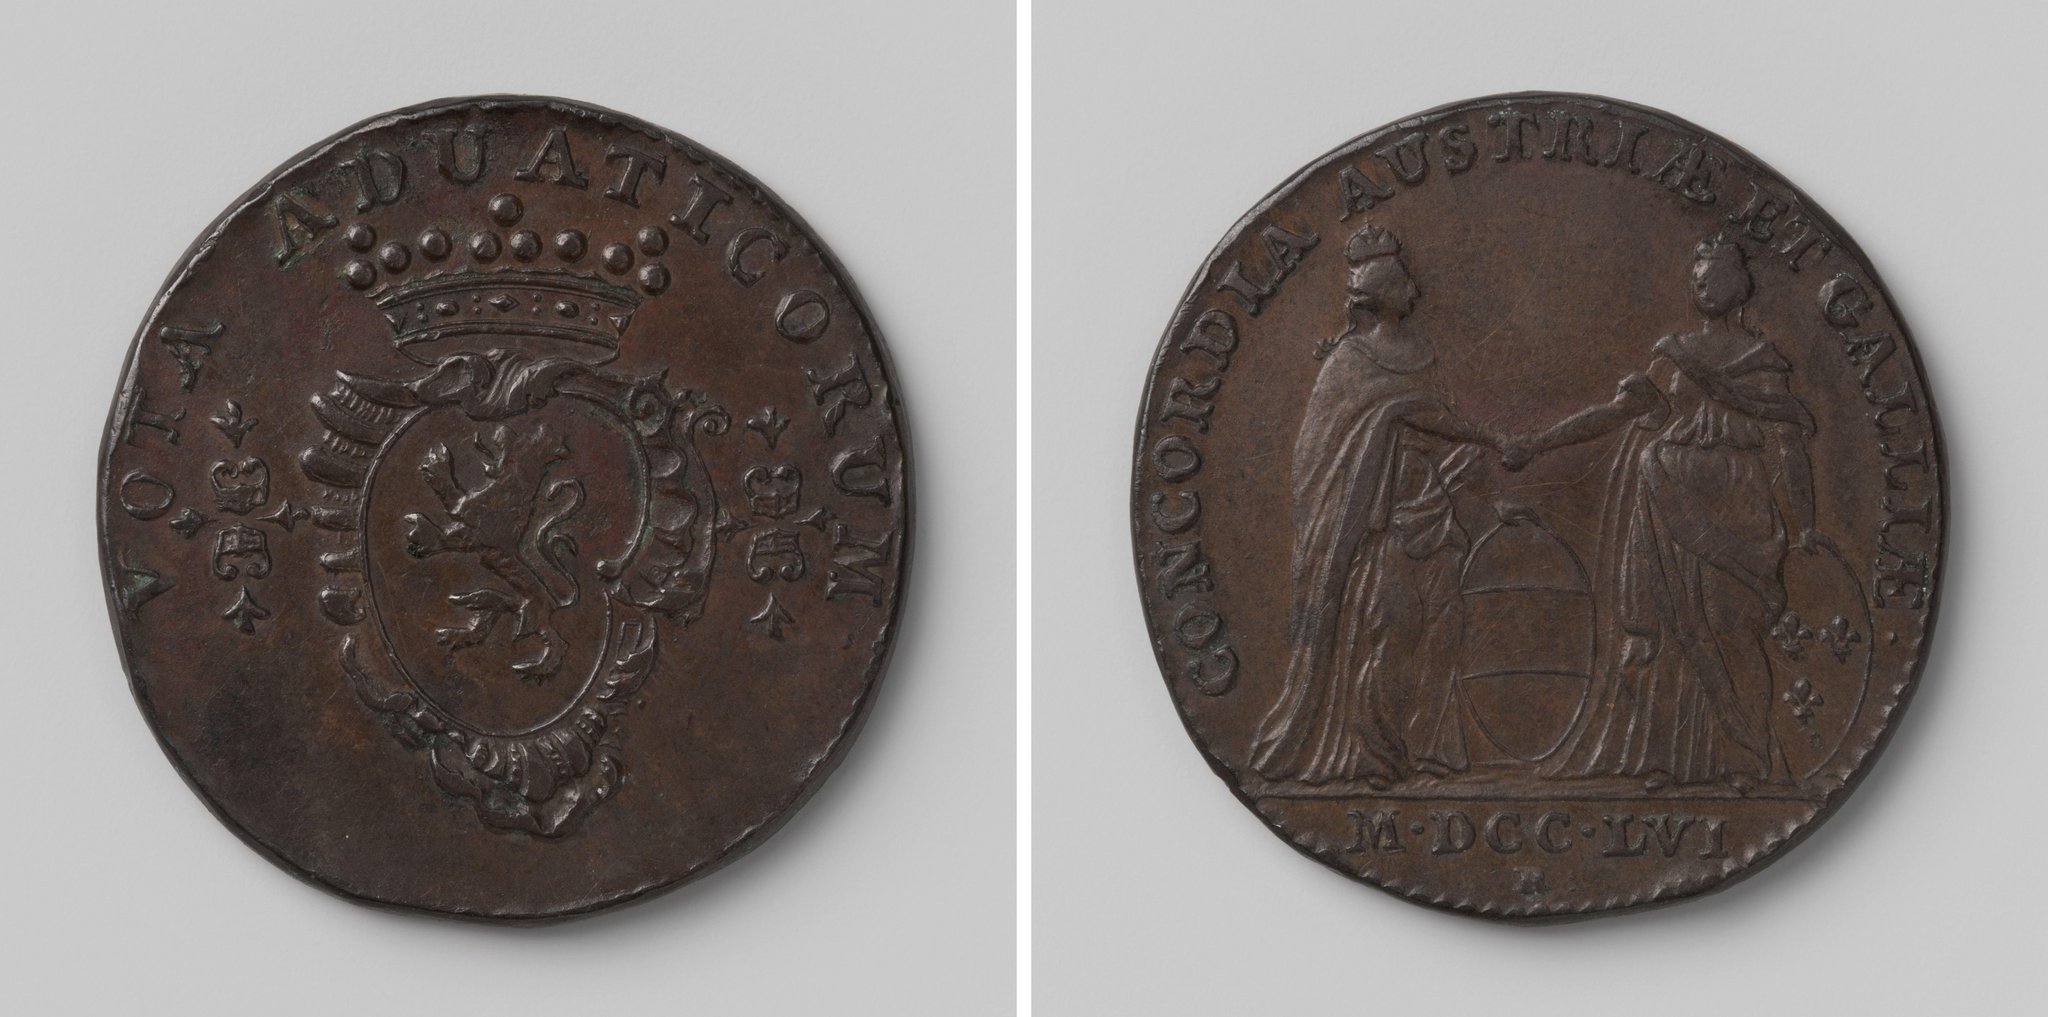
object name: jeton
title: Verdrag van Versaille tussen Oostenrijk en Frankrijk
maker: jacques roëttiers (ii)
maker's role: medailleur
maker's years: 1698-1772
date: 1756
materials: copper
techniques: striking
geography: antwerp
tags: namur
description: Koperen penning. Voorzijde: gekroond wapenschild in cartouche, geflankeerd door twee vuurslagen aan elke zijde binnen omschrift. Keerzijde: twee gekroonde vrouwen met wapenschild, voorstellende Oostenrijk en Frankrijk reiken elkaar hand binnen omschrift; afsnede: jaartal.